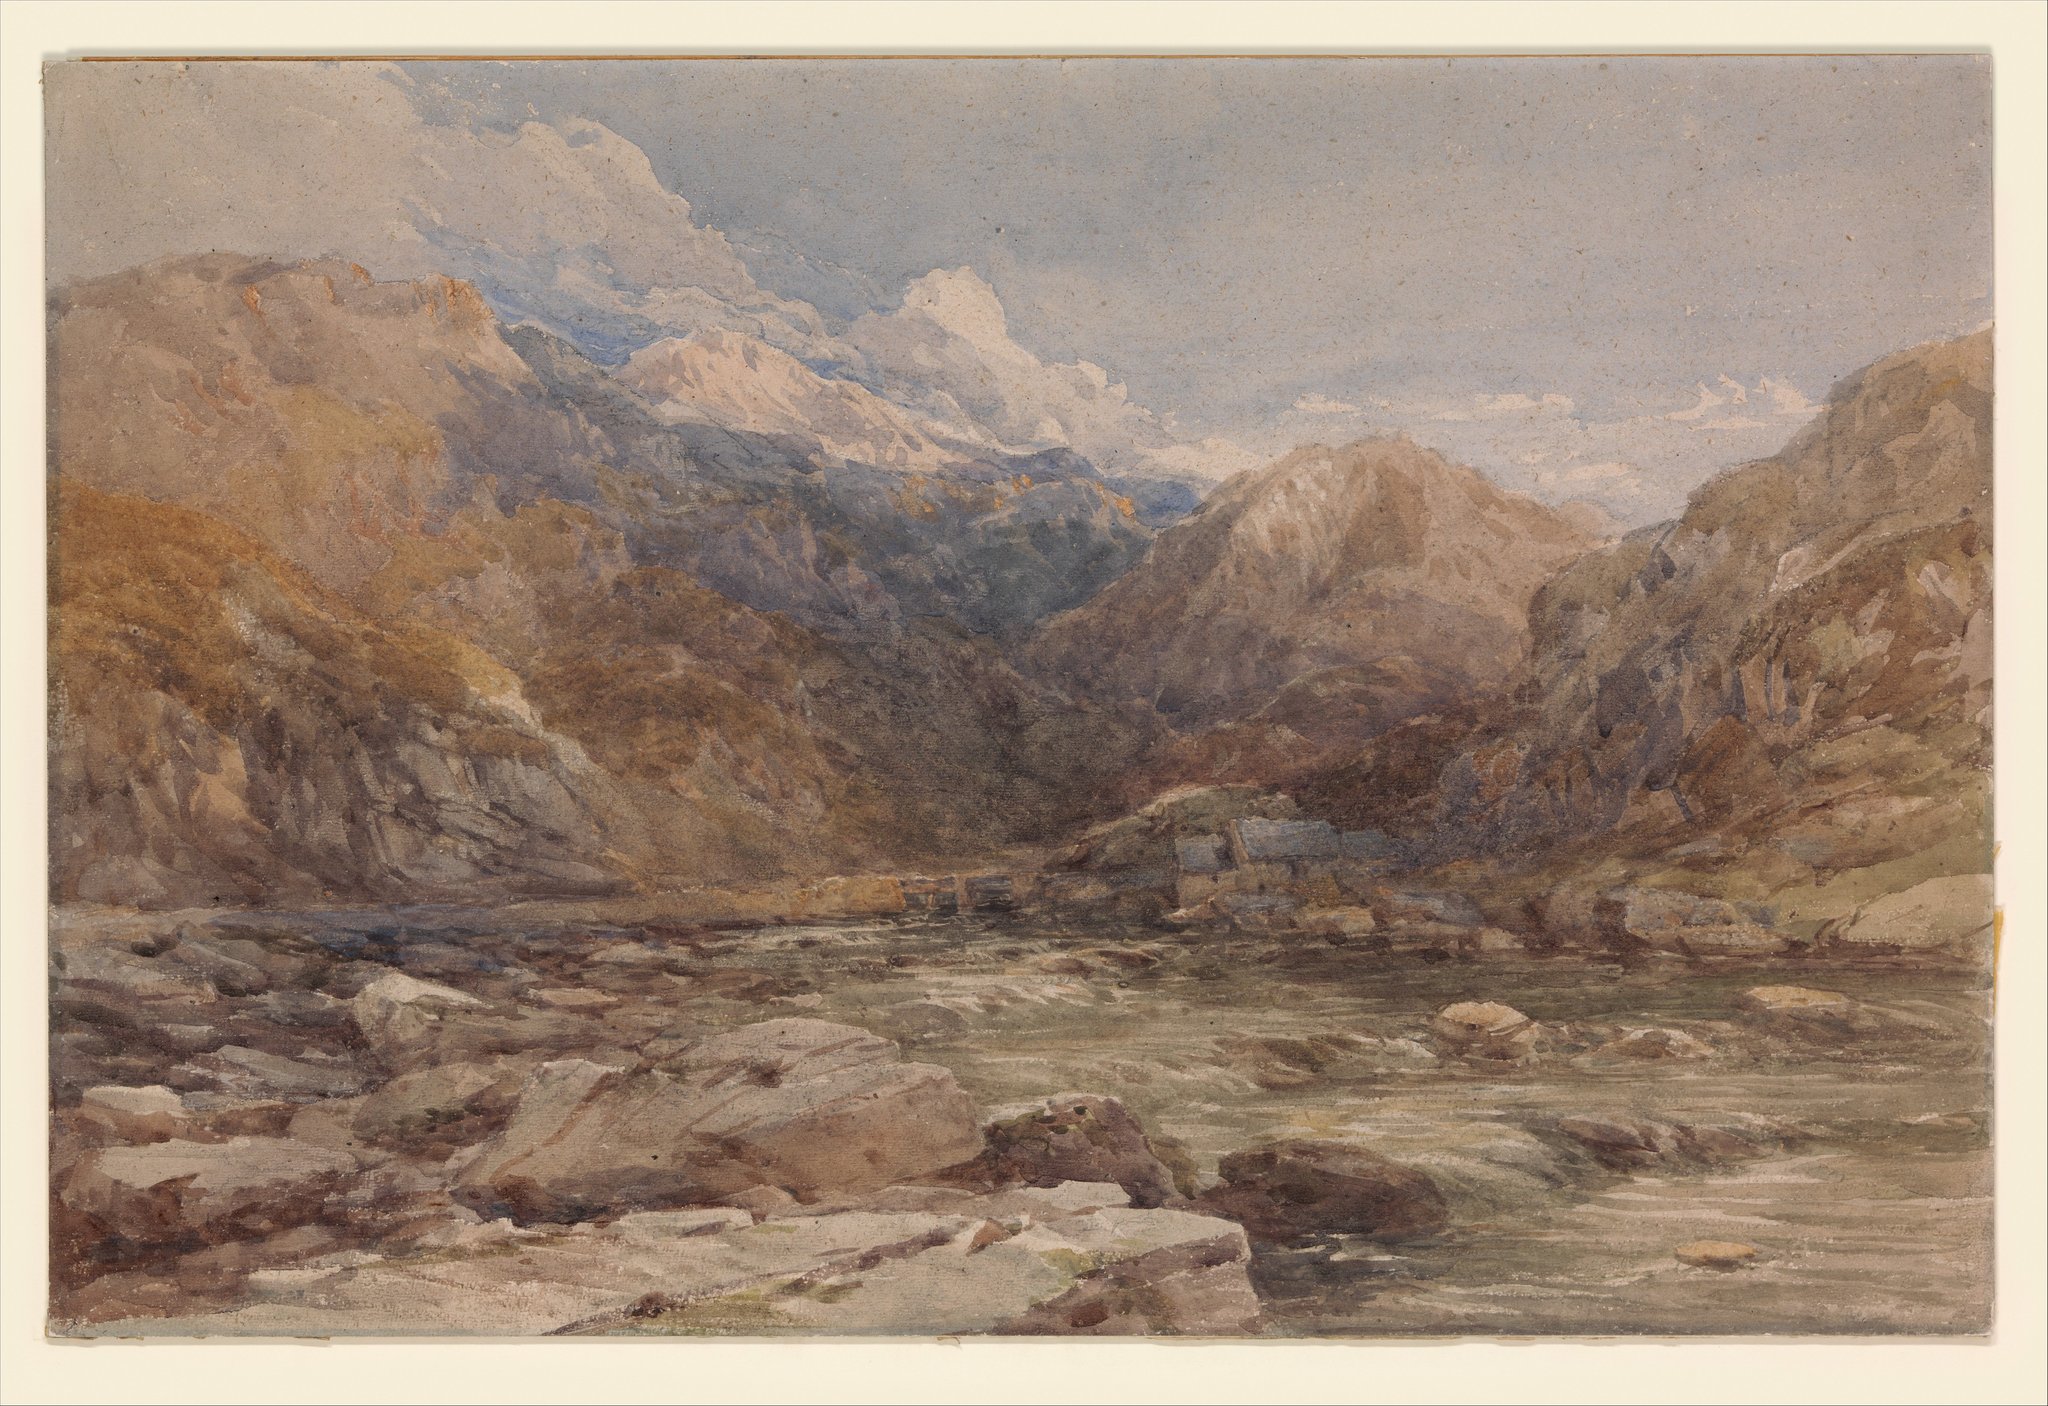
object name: drawing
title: River Landscape in Wales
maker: david cox, the elder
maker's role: artist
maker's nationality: english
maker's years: 1783-1859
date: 1850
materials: board, chalk, gouache, paper, watercolor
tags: rivers,mountains,landscapes